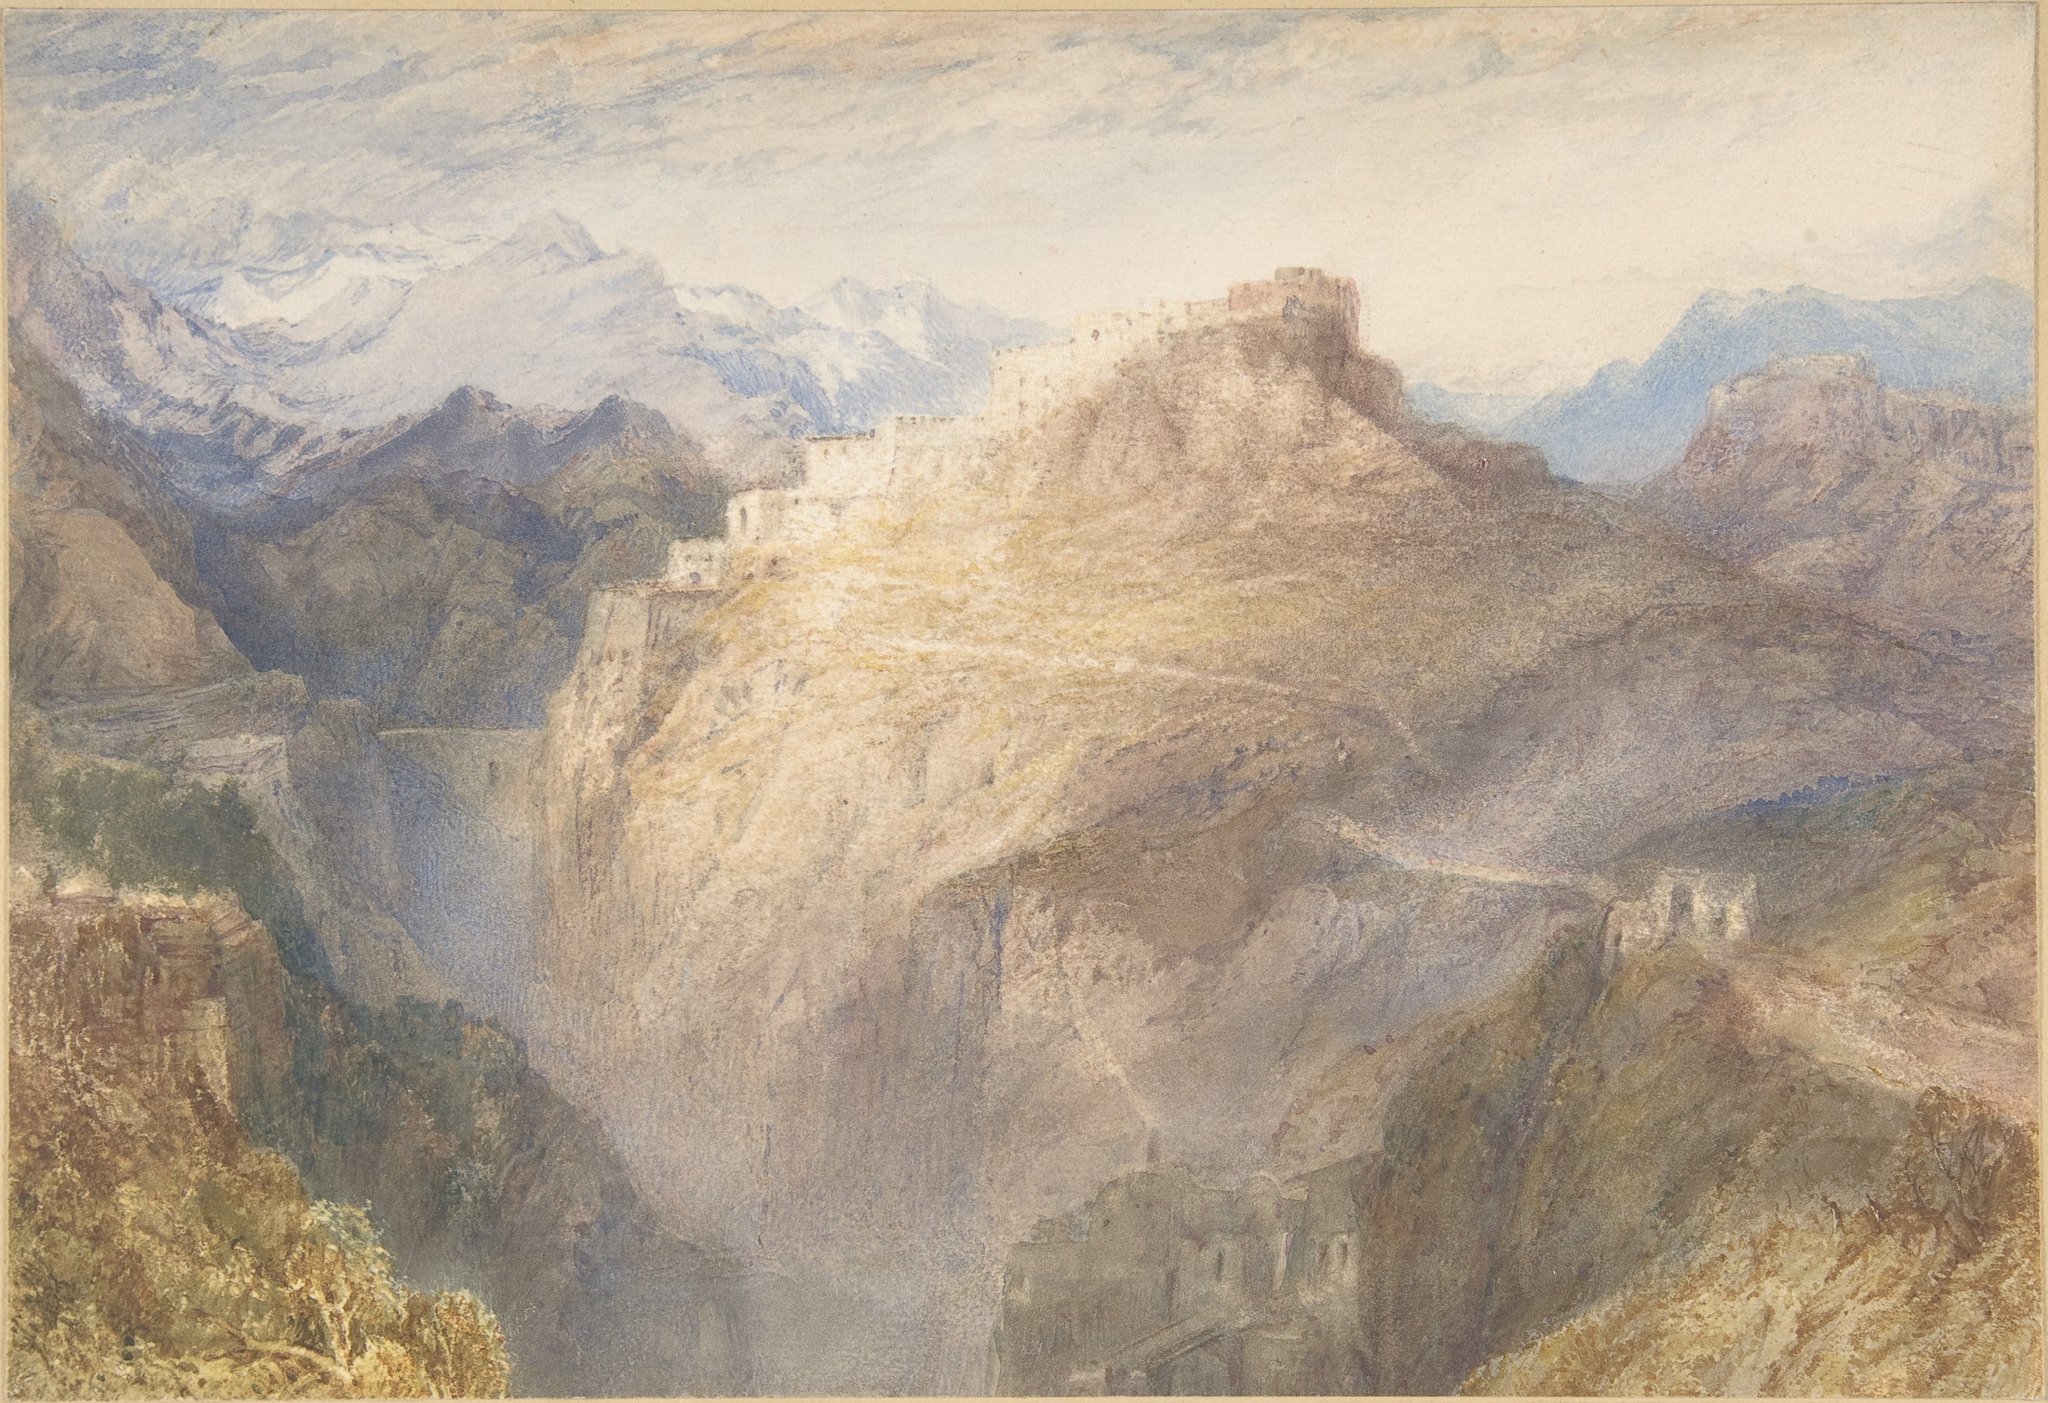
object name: drawing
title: The Fort of L'Esseillon, Val de la Maurienne, France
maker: joseph mallord william turner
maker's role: artist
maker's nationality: british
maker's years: 1775-1851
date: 1835-1836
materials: watercolor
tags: mountains,landscapes